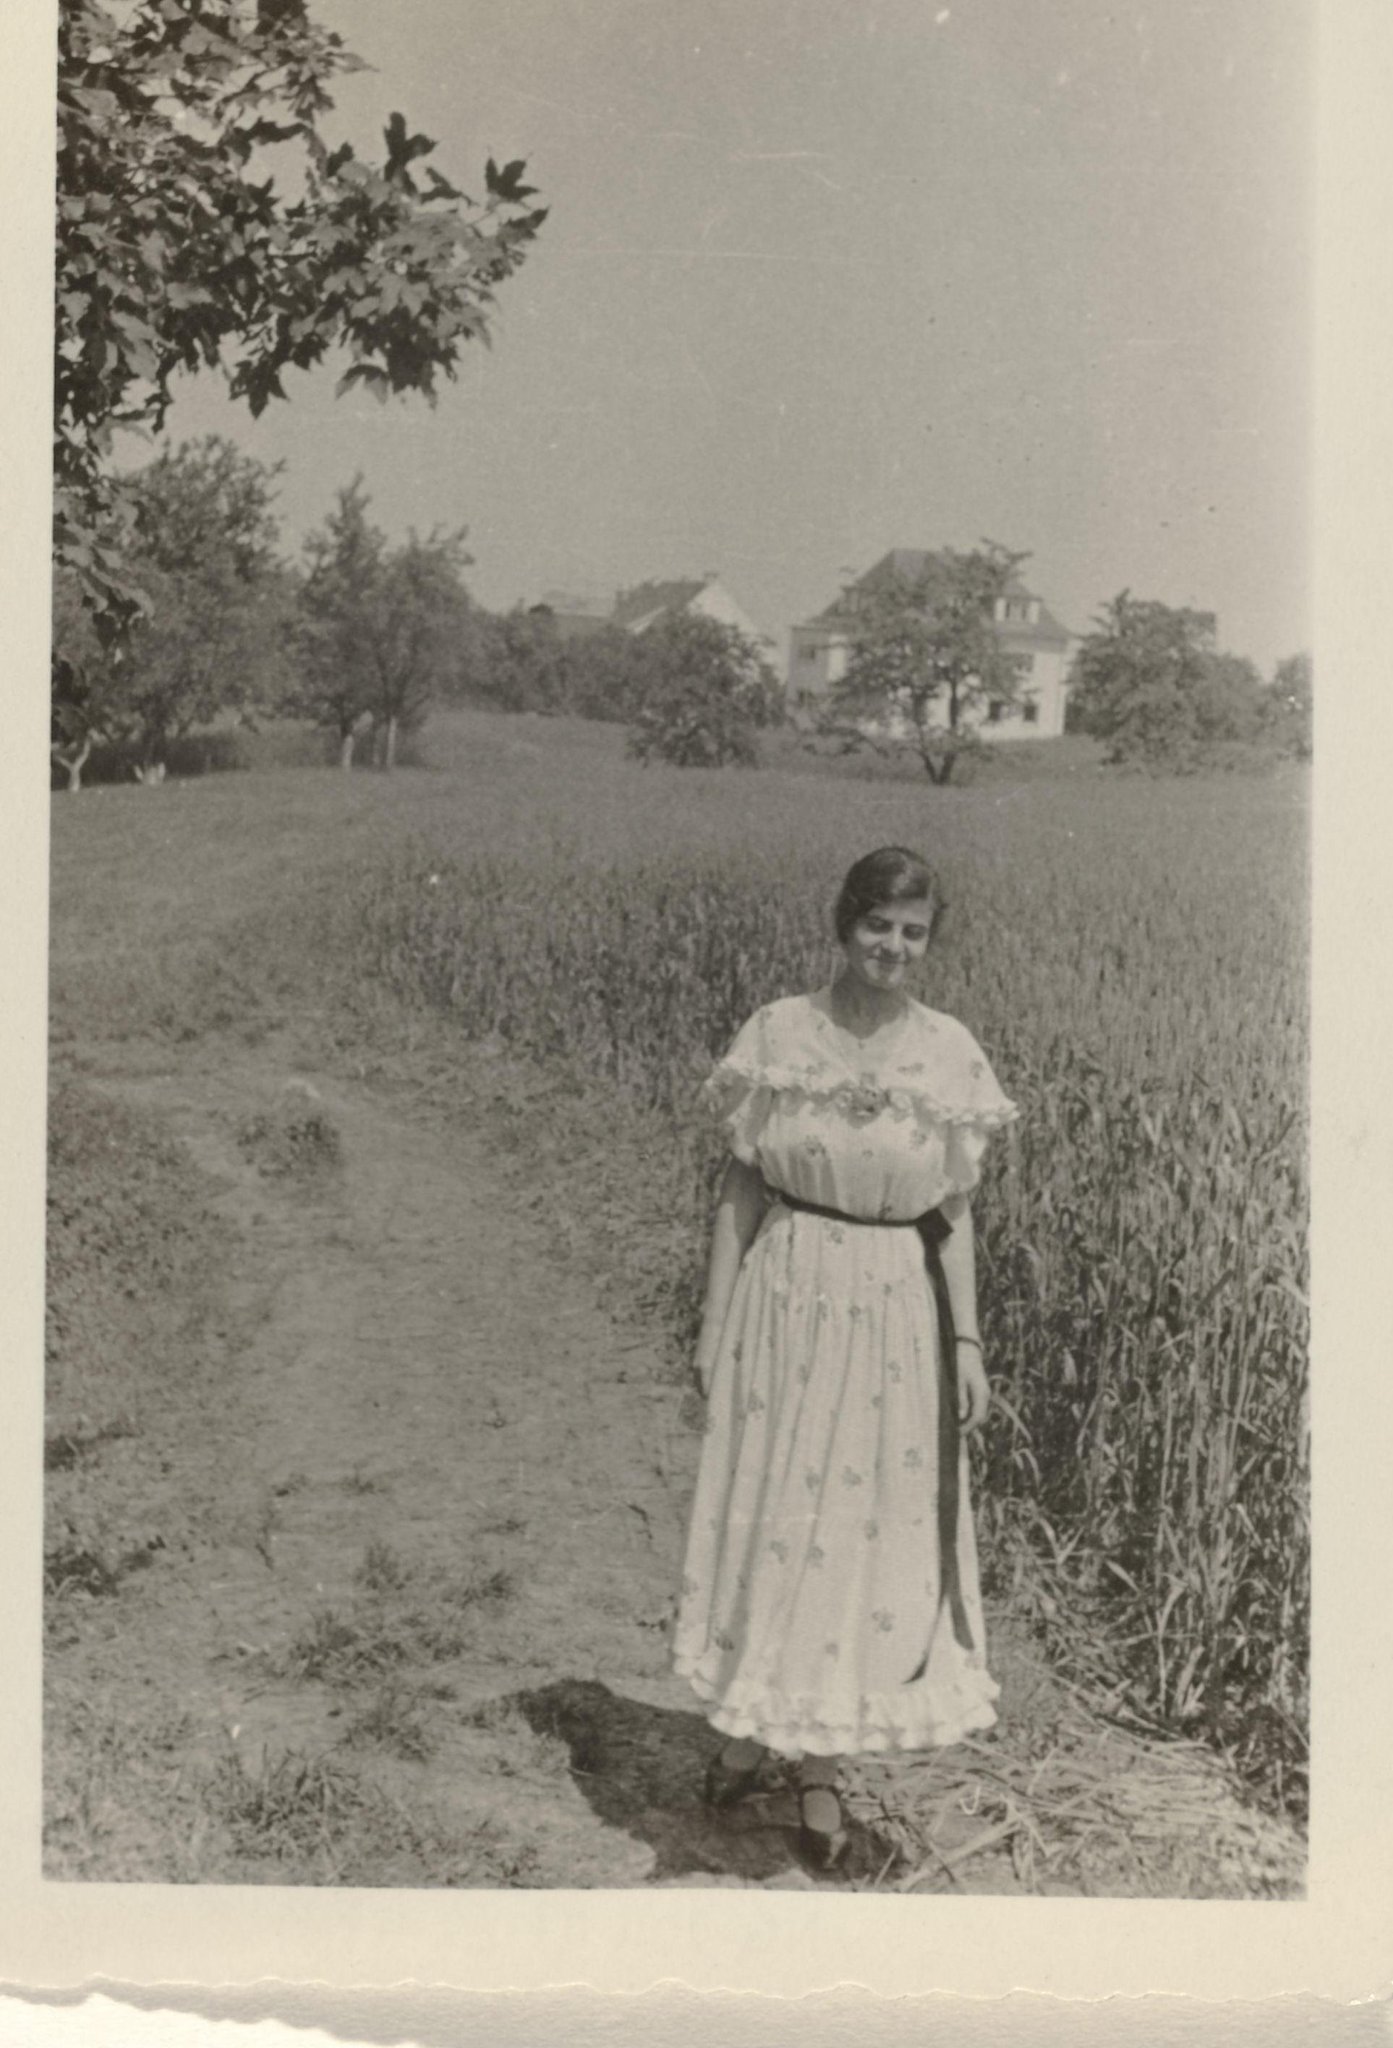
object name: photograph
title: Lid van de huishoudelijk staf van de familie Wachenheimer, mogelijk het kindermeisje, in gestipte jurk staand naast een veld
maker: Anonymous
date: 1933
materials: photographic support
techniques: gelatin silver print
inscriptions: date: ‘2. Juli 33.’